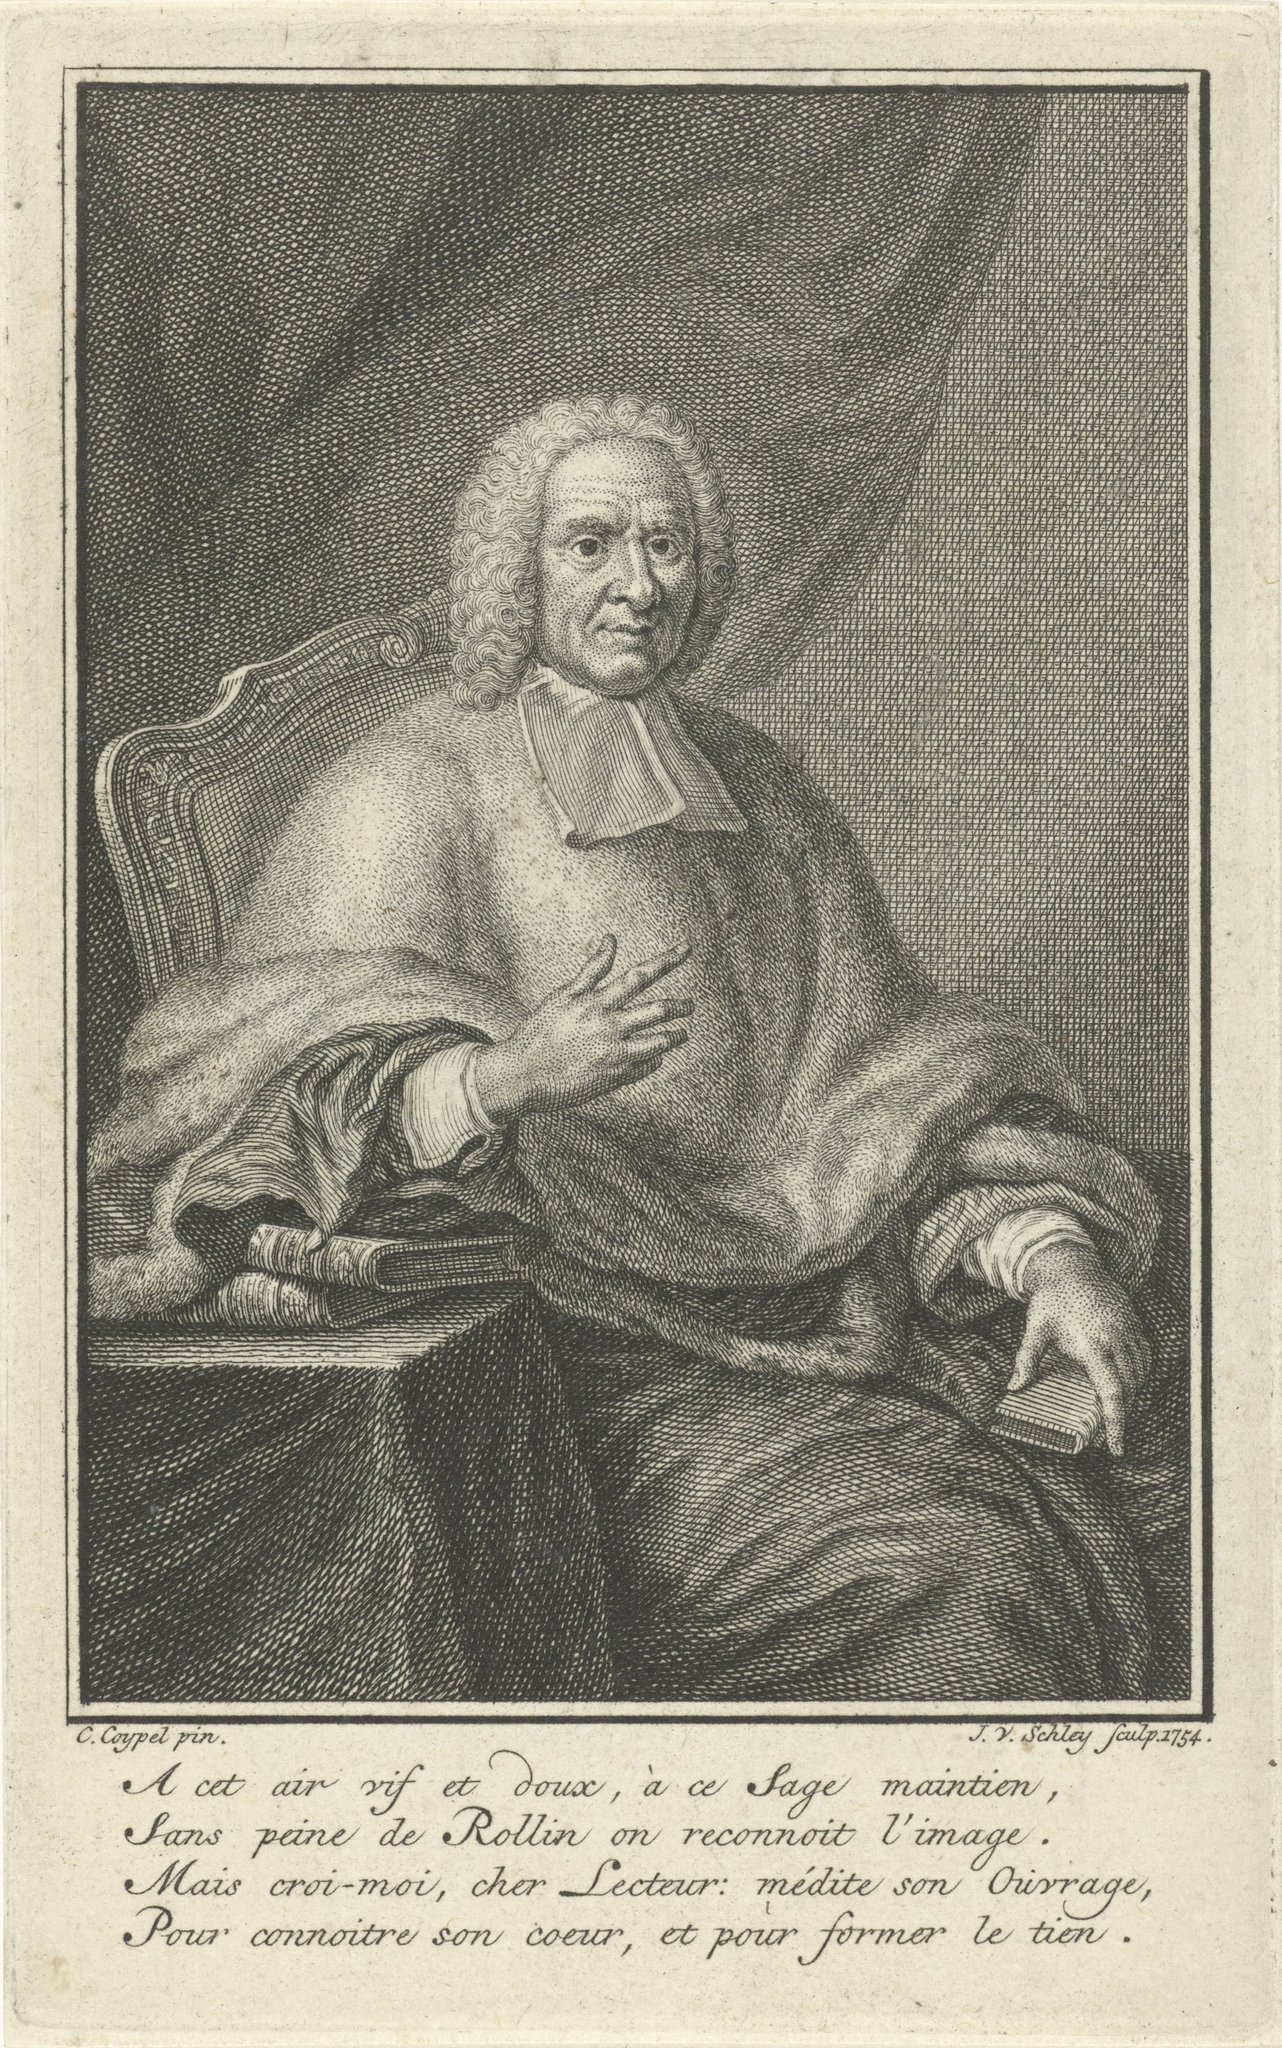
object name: print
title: Portret van Charles Rollin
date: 1754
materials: paper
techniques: engraving, etching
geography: amsterdam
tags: paris, charles rollin, wig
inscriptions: collector's mark: Lugt 2228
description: Portret van Charles Rollin, Frans pedagoog en historicus, en vanaf 1694 rector van de universiteit van Parijs. In de marge een gedicht in het Frans.